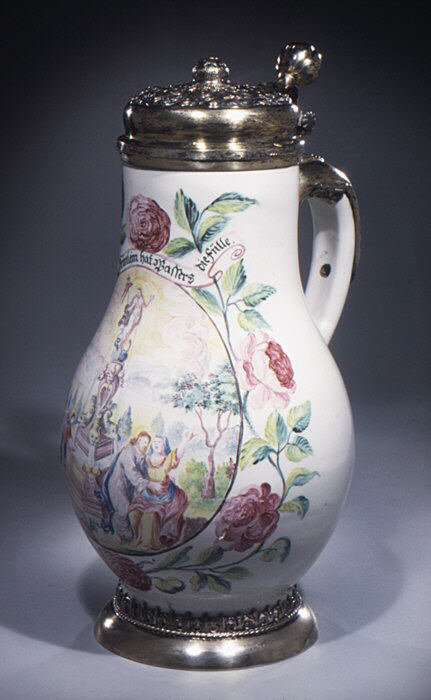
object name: jug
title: Jug (Krug)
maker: abraham helmhack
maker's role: decorator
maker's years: 1654-1724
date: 1667-1700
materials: faience, silver gilt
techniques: glazing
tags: human figures,flowers